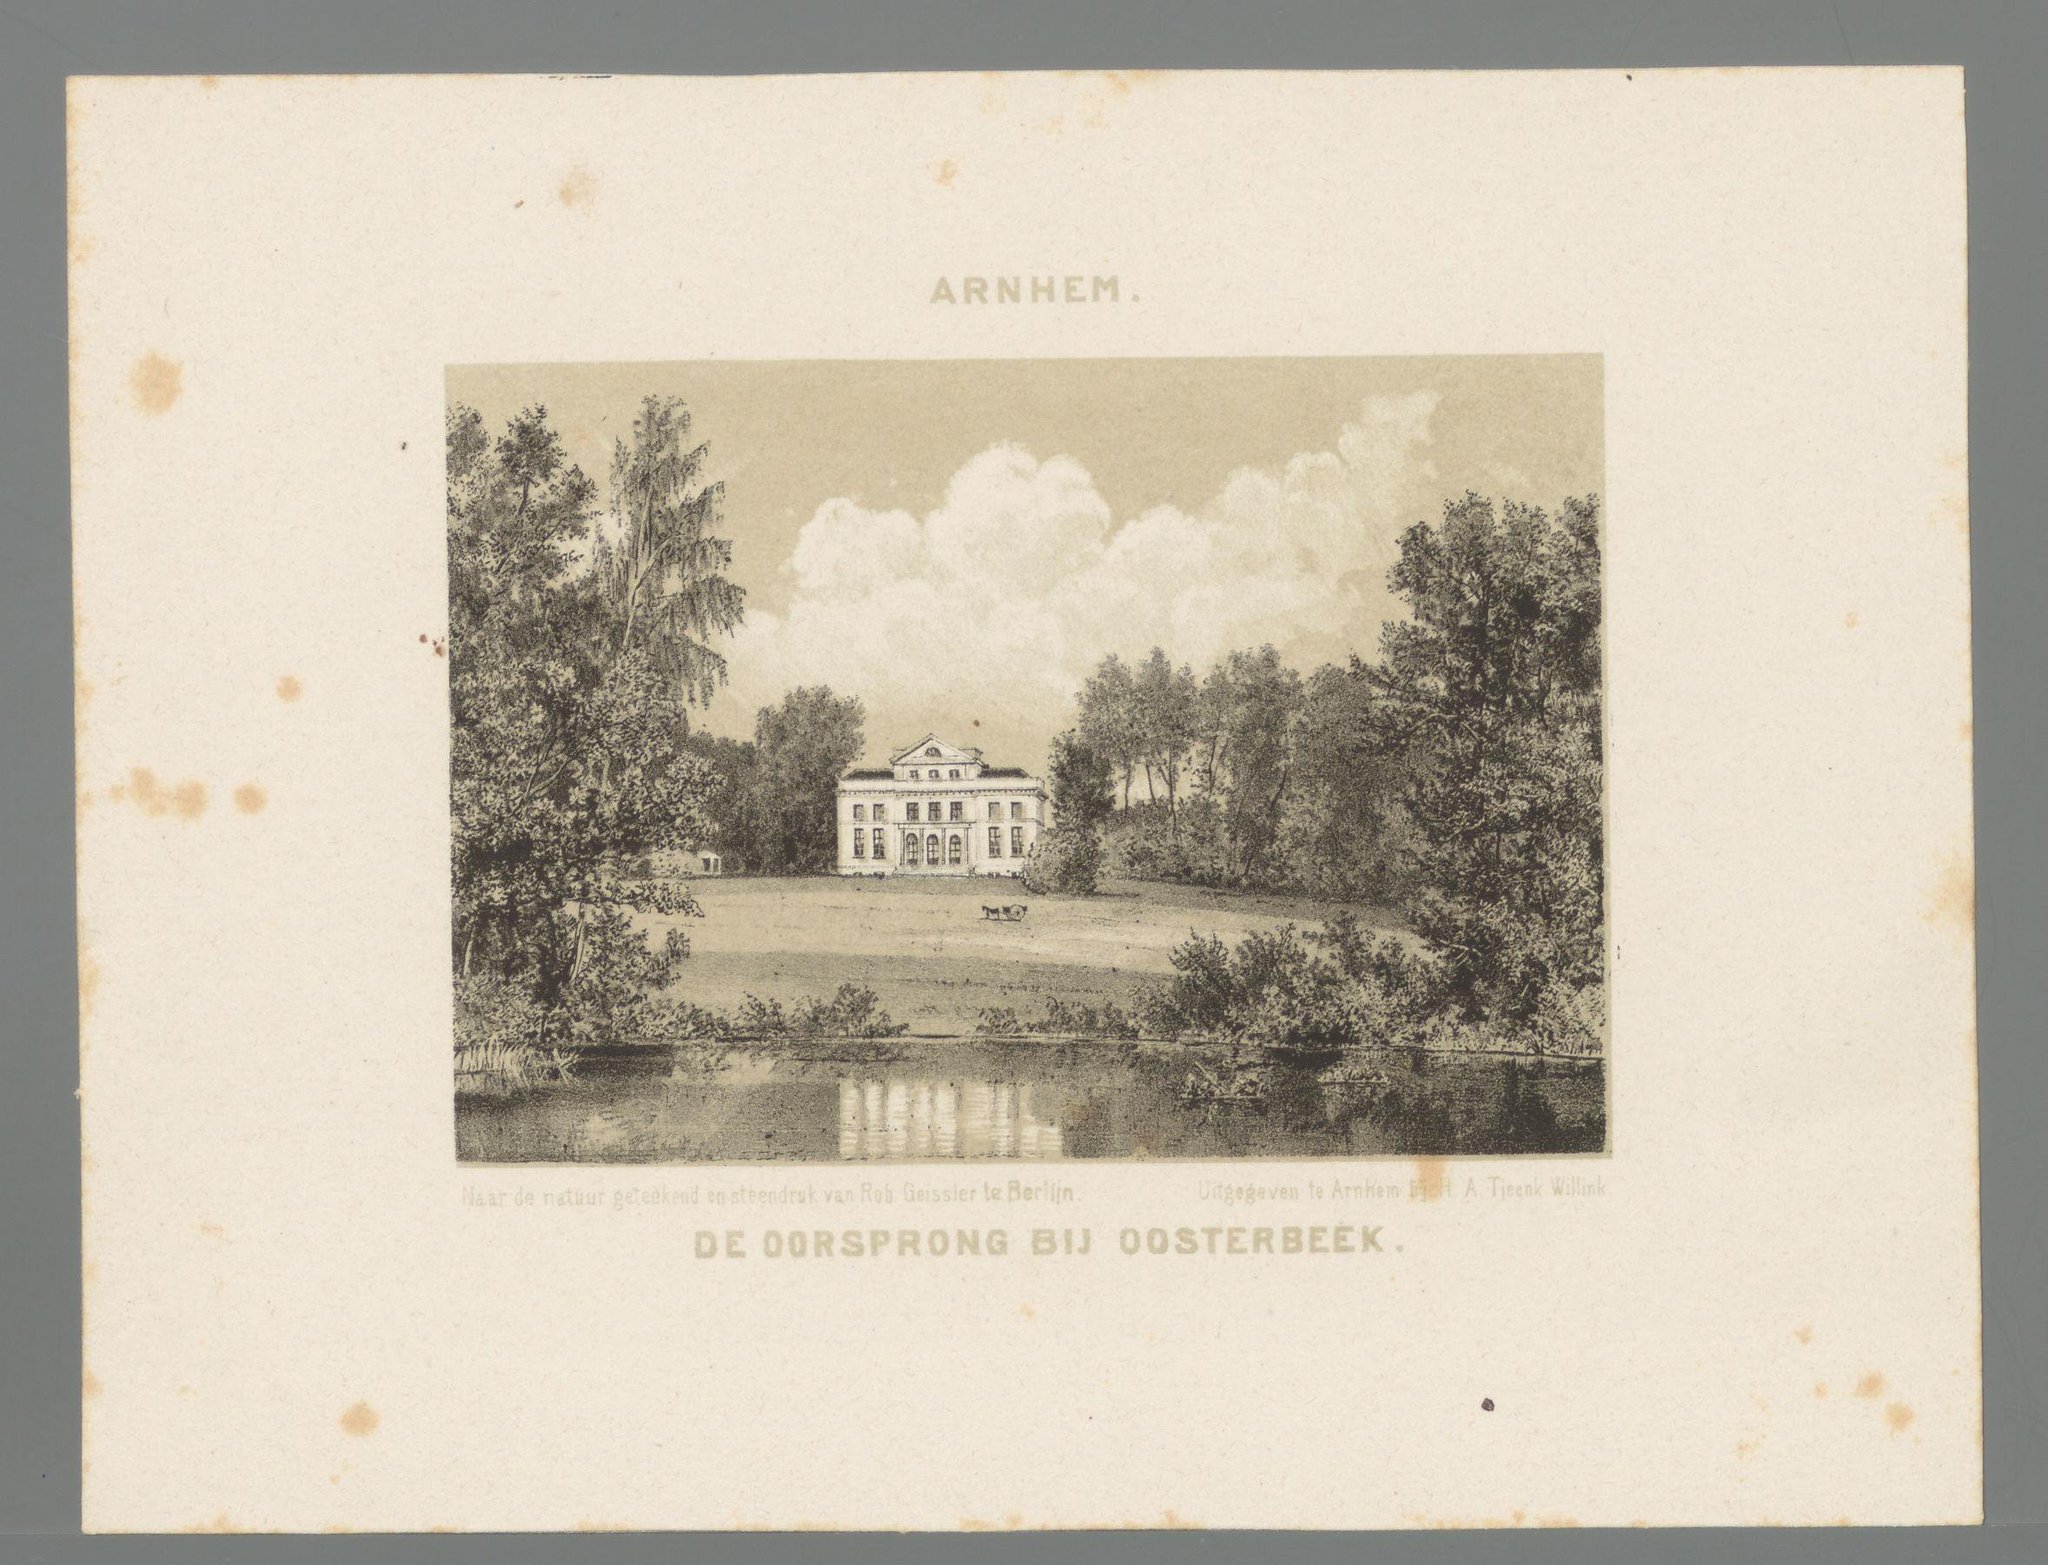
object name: print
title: Souvenir aan Arnhem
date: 1865-1875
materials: paper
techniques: tone lithography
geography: berlin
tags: rural housing, e.g. country-house, villa, cottage, arnhem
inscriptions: collector's mark: Lugt 2228